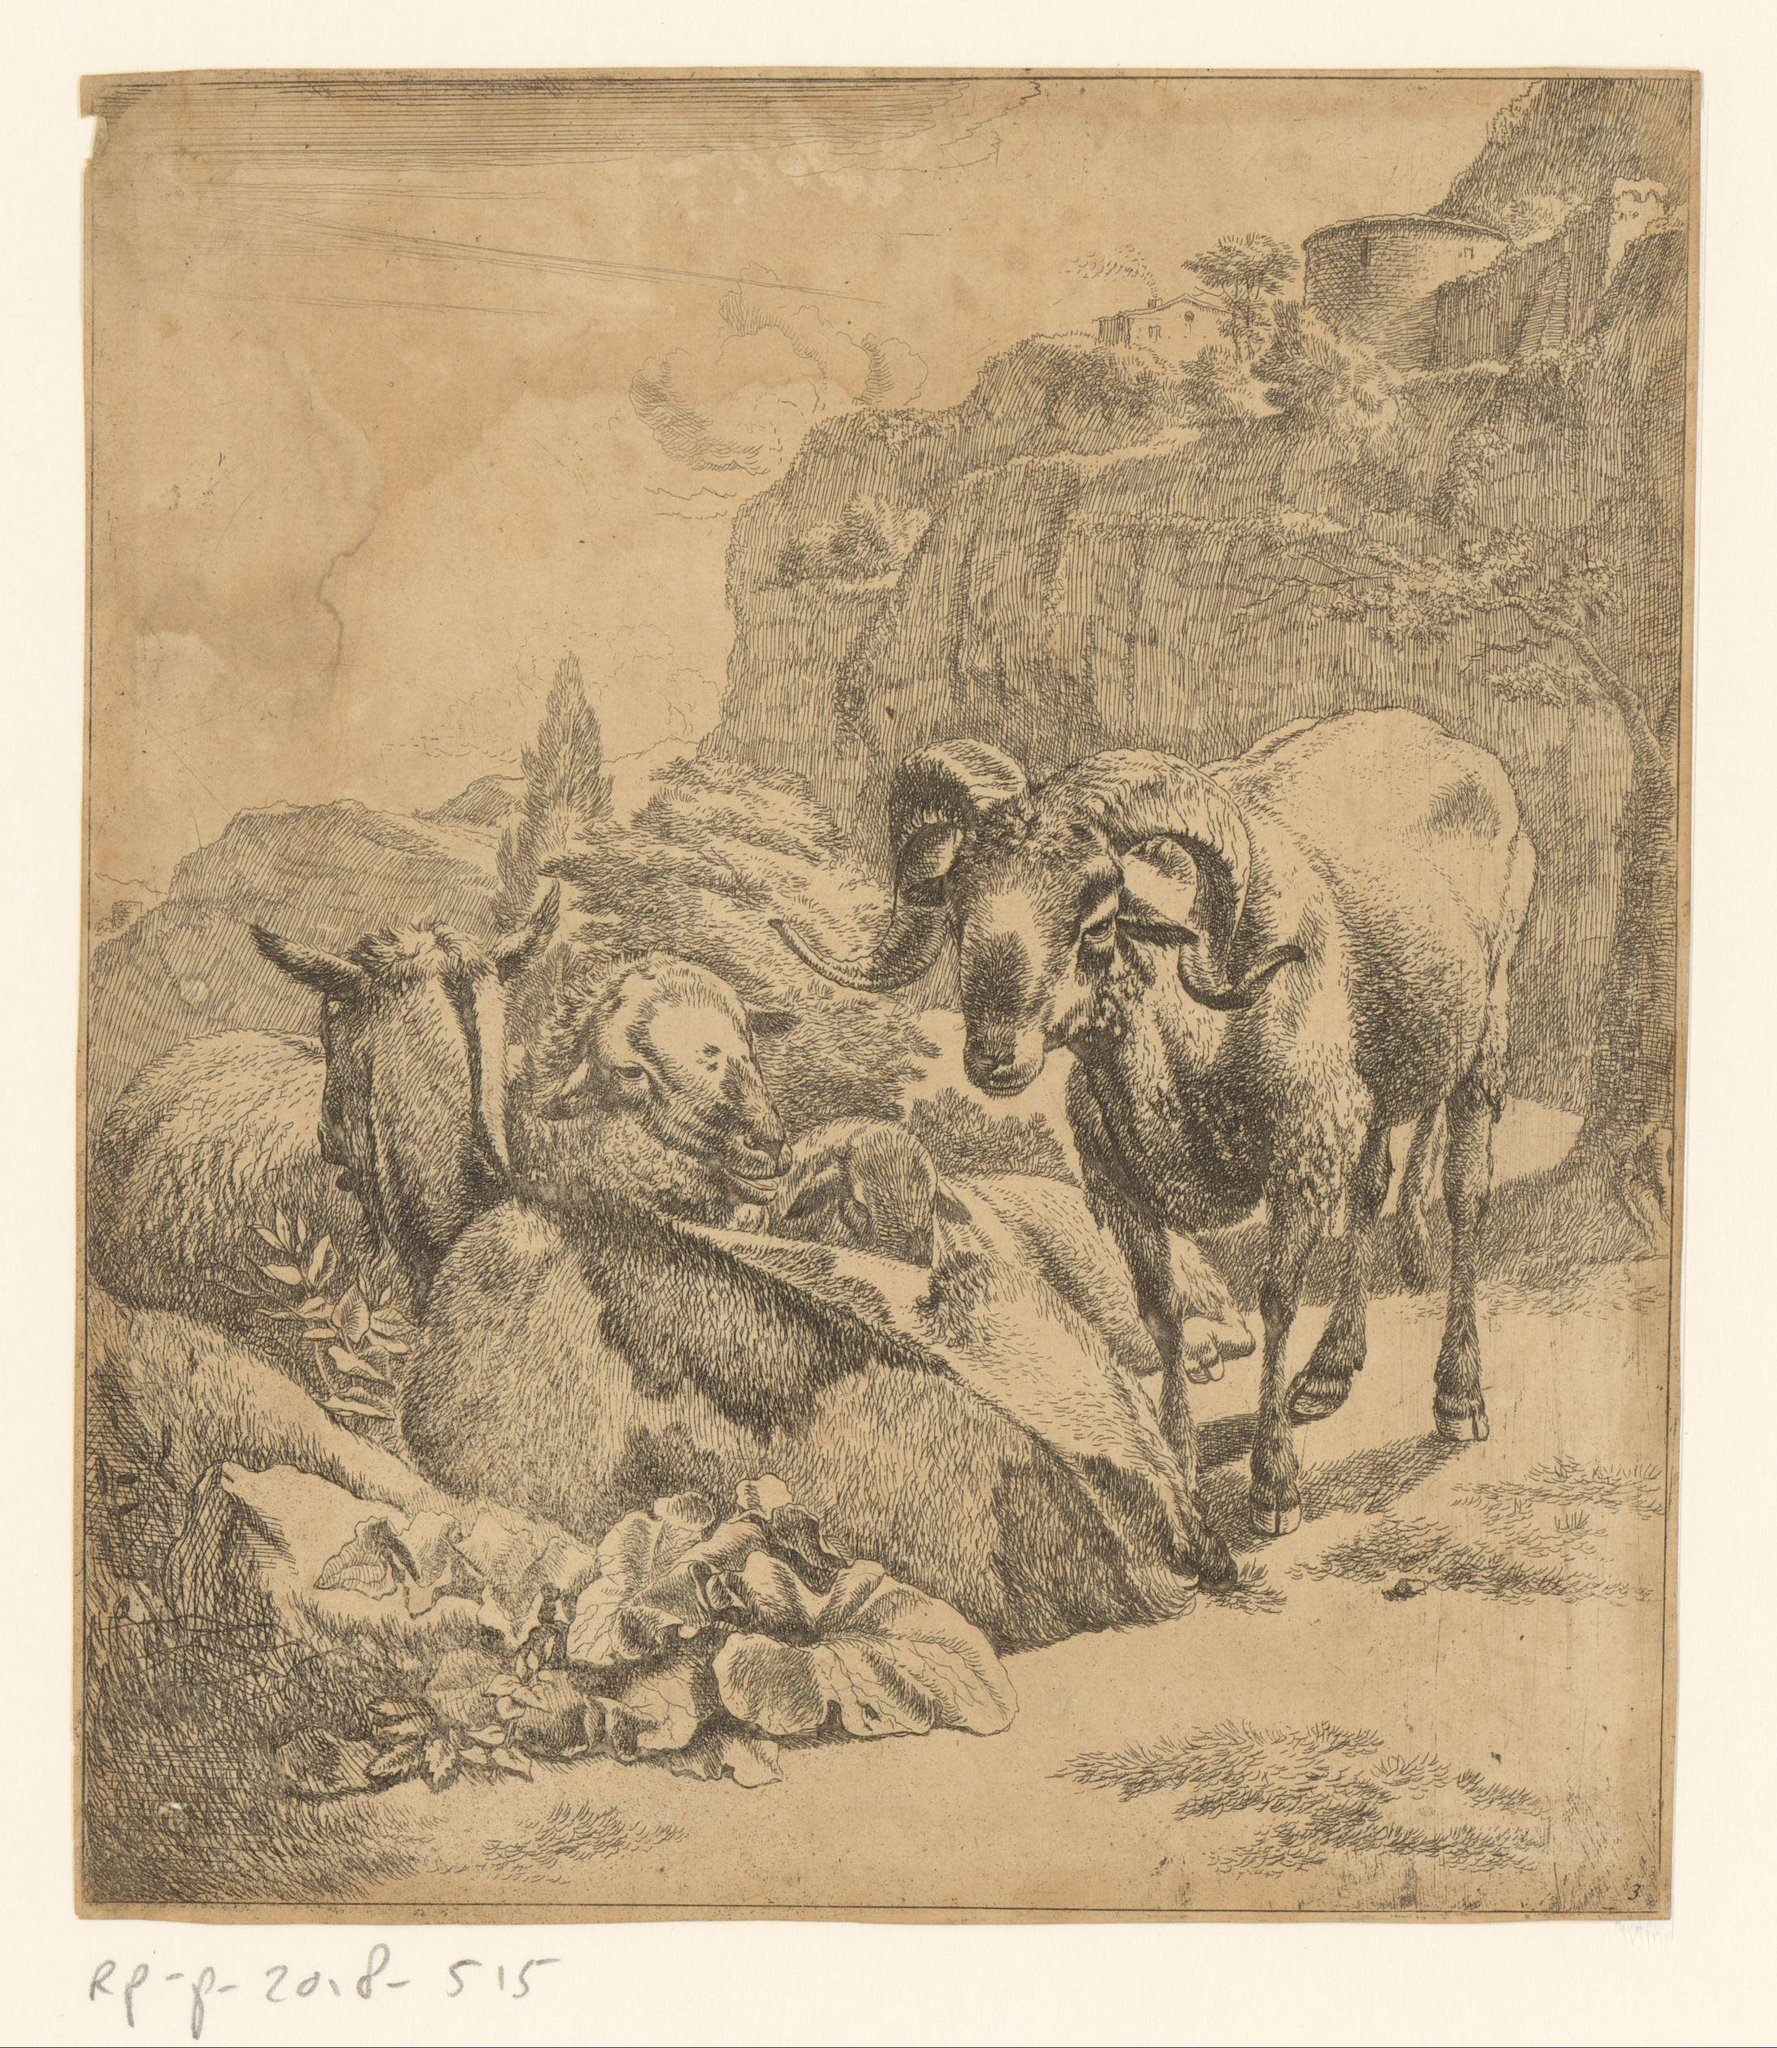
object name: print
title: Staande ram, liggende geit en twee schapen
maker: johann heinrich roos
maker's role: draughtsman, print maker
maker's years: 1631-1685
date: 1671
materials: paper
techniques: engraving, etching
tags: landscapes, ram, sheep, goat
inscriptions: collector's mark: Lugt 2228, collector's mark: Lugt 1697